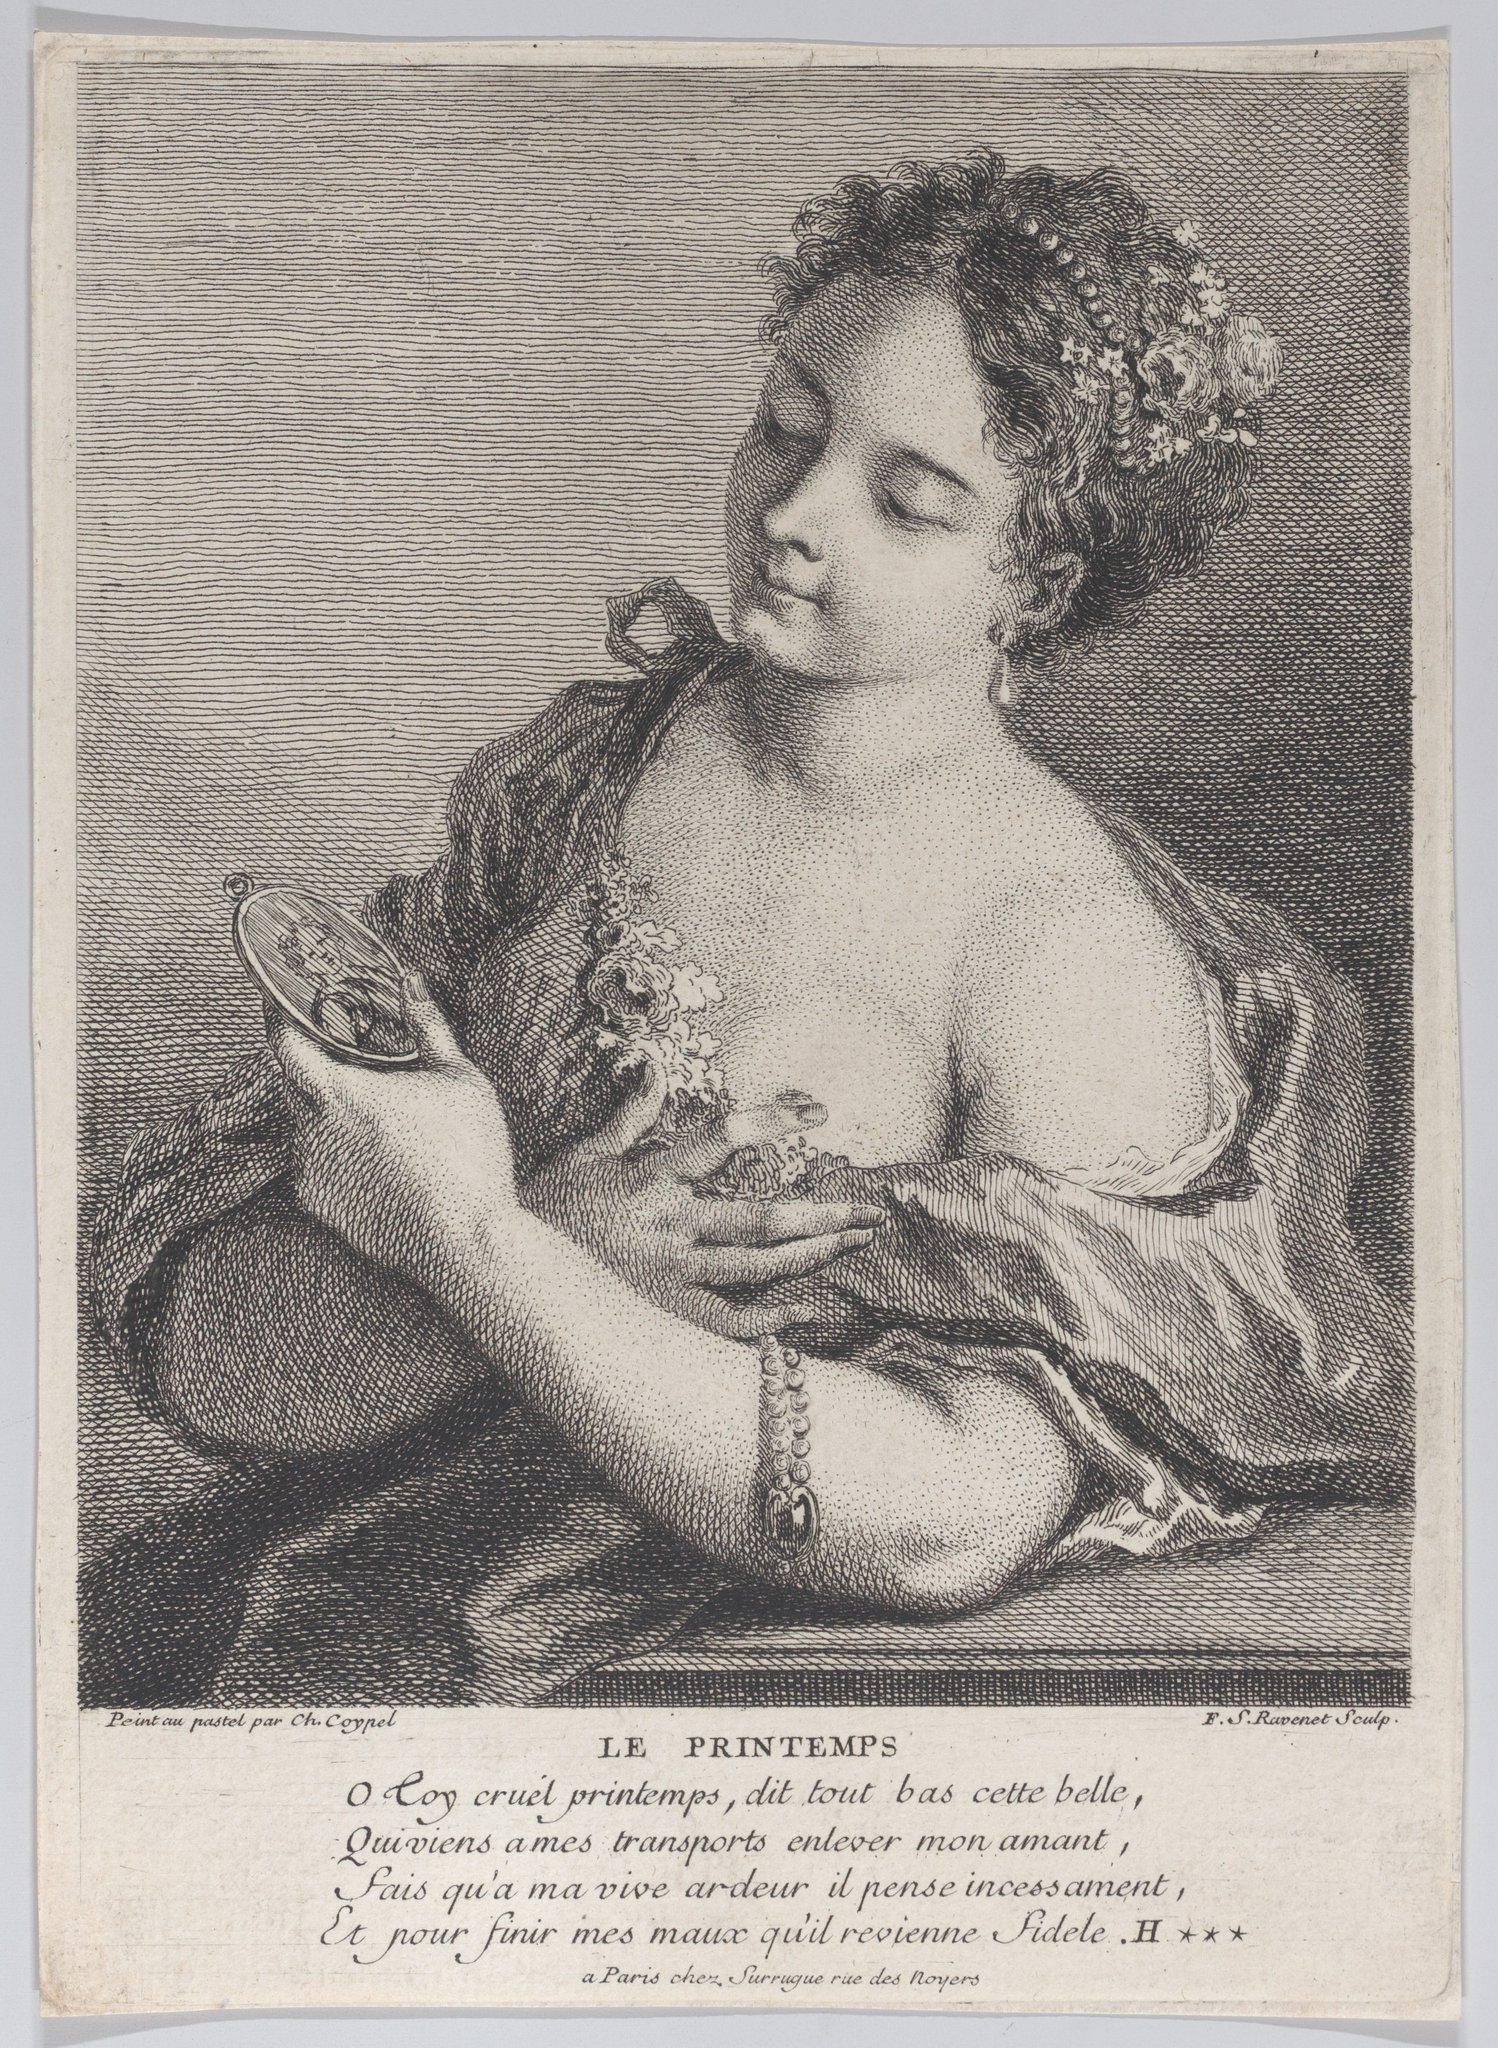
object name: print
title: Spring (Le Printemps)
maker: simon francis ravenet, the elder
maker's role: artist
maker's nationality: french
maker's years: 1706-1774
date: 1742-1762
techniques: engraving, etching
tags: women